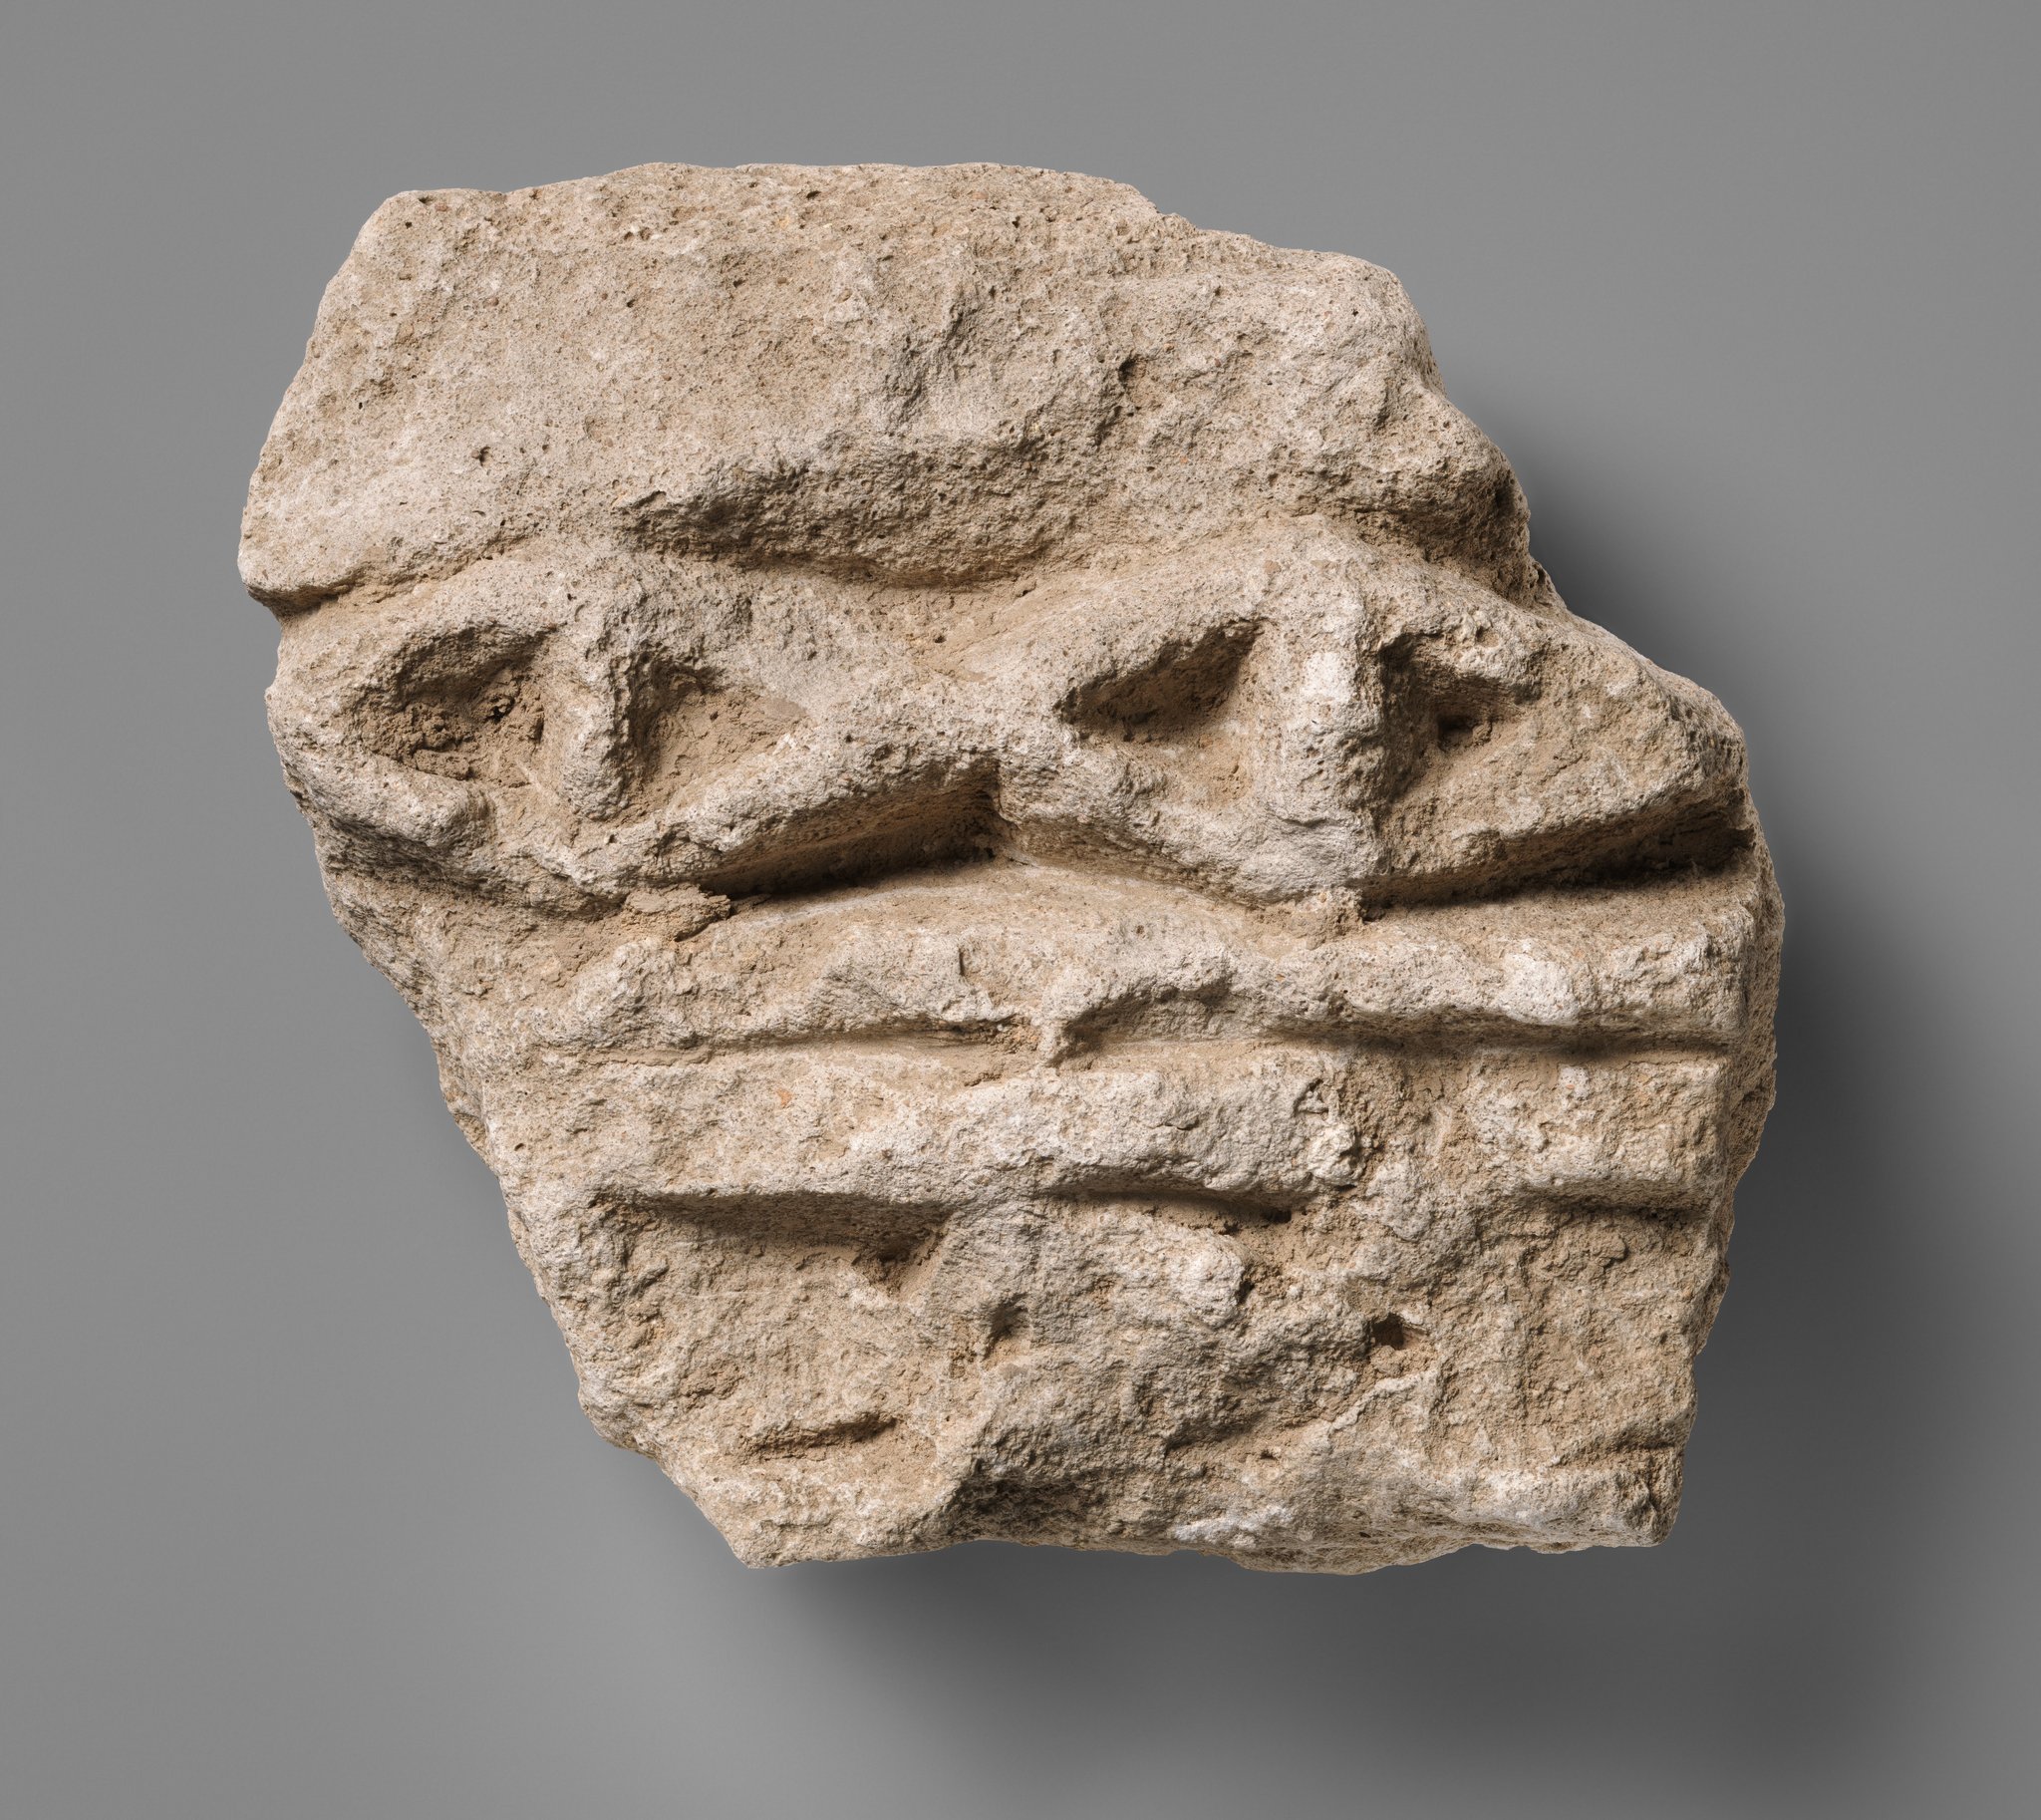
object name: relief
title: Relief fragment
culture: sasanian or islamic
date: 501-800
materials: plaster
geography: mesopotamia